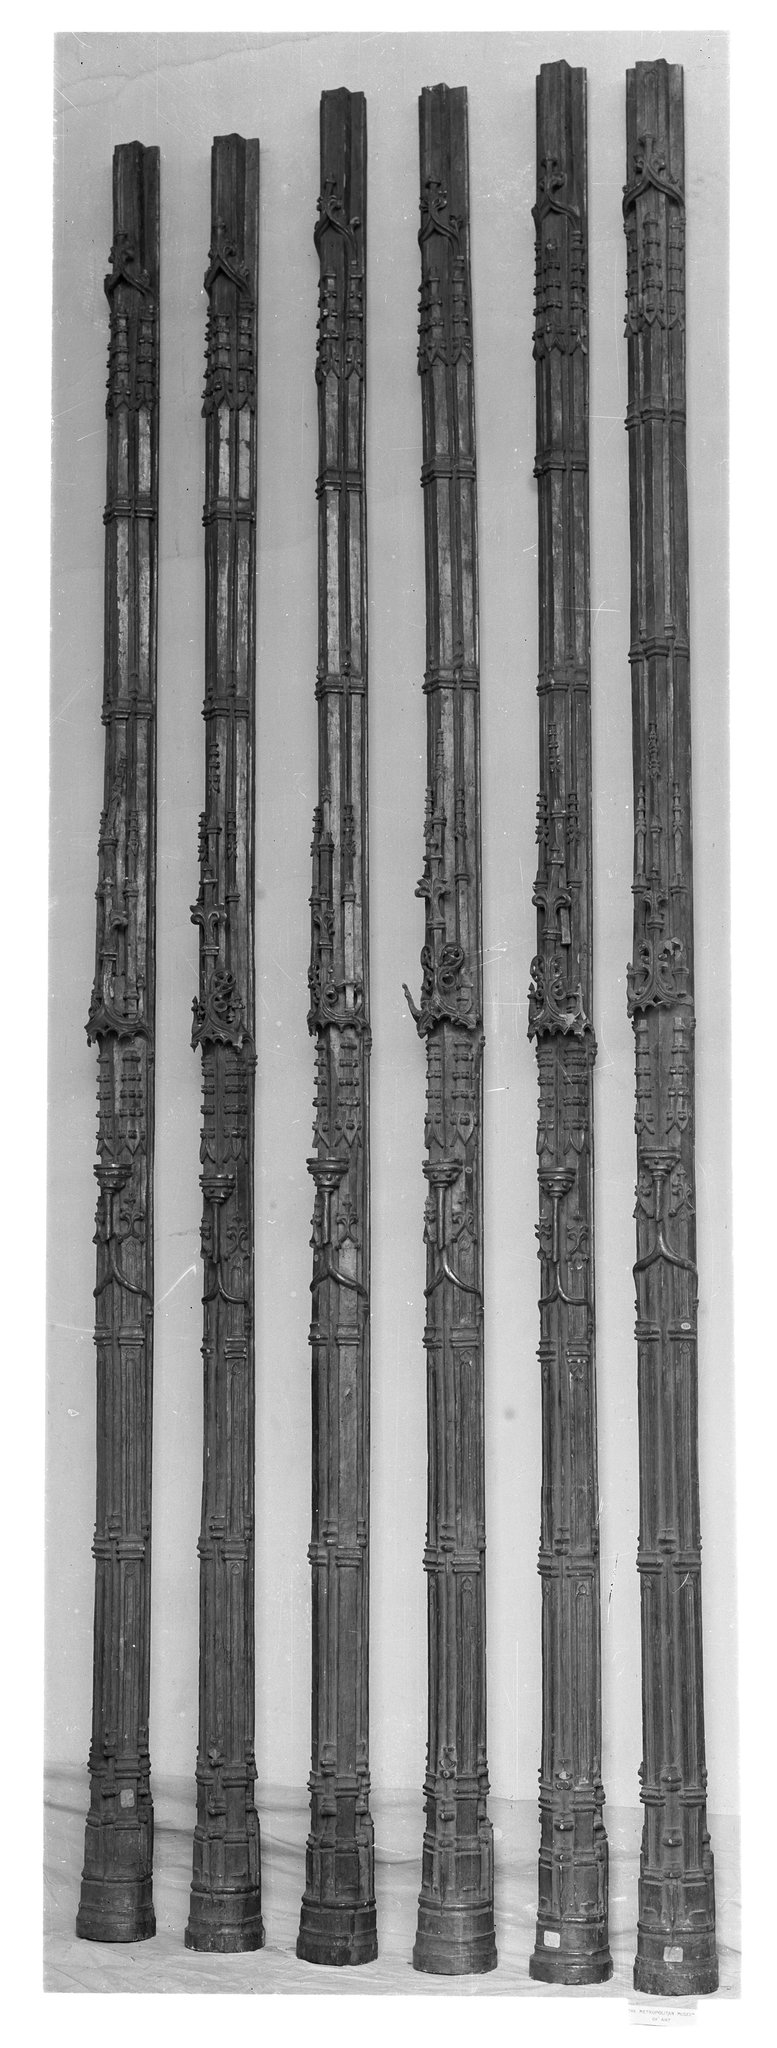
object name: pilaster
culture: french or italian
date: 1501-1600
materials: gold leaf, wood